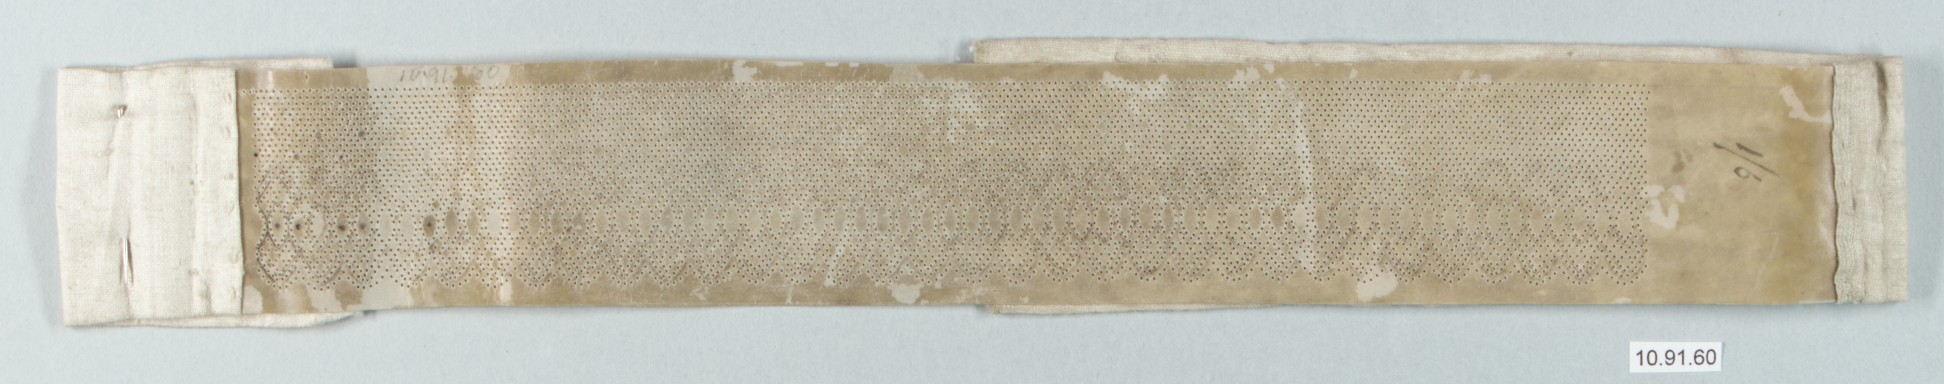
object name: pattern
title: Lace patterns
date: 1701-1900